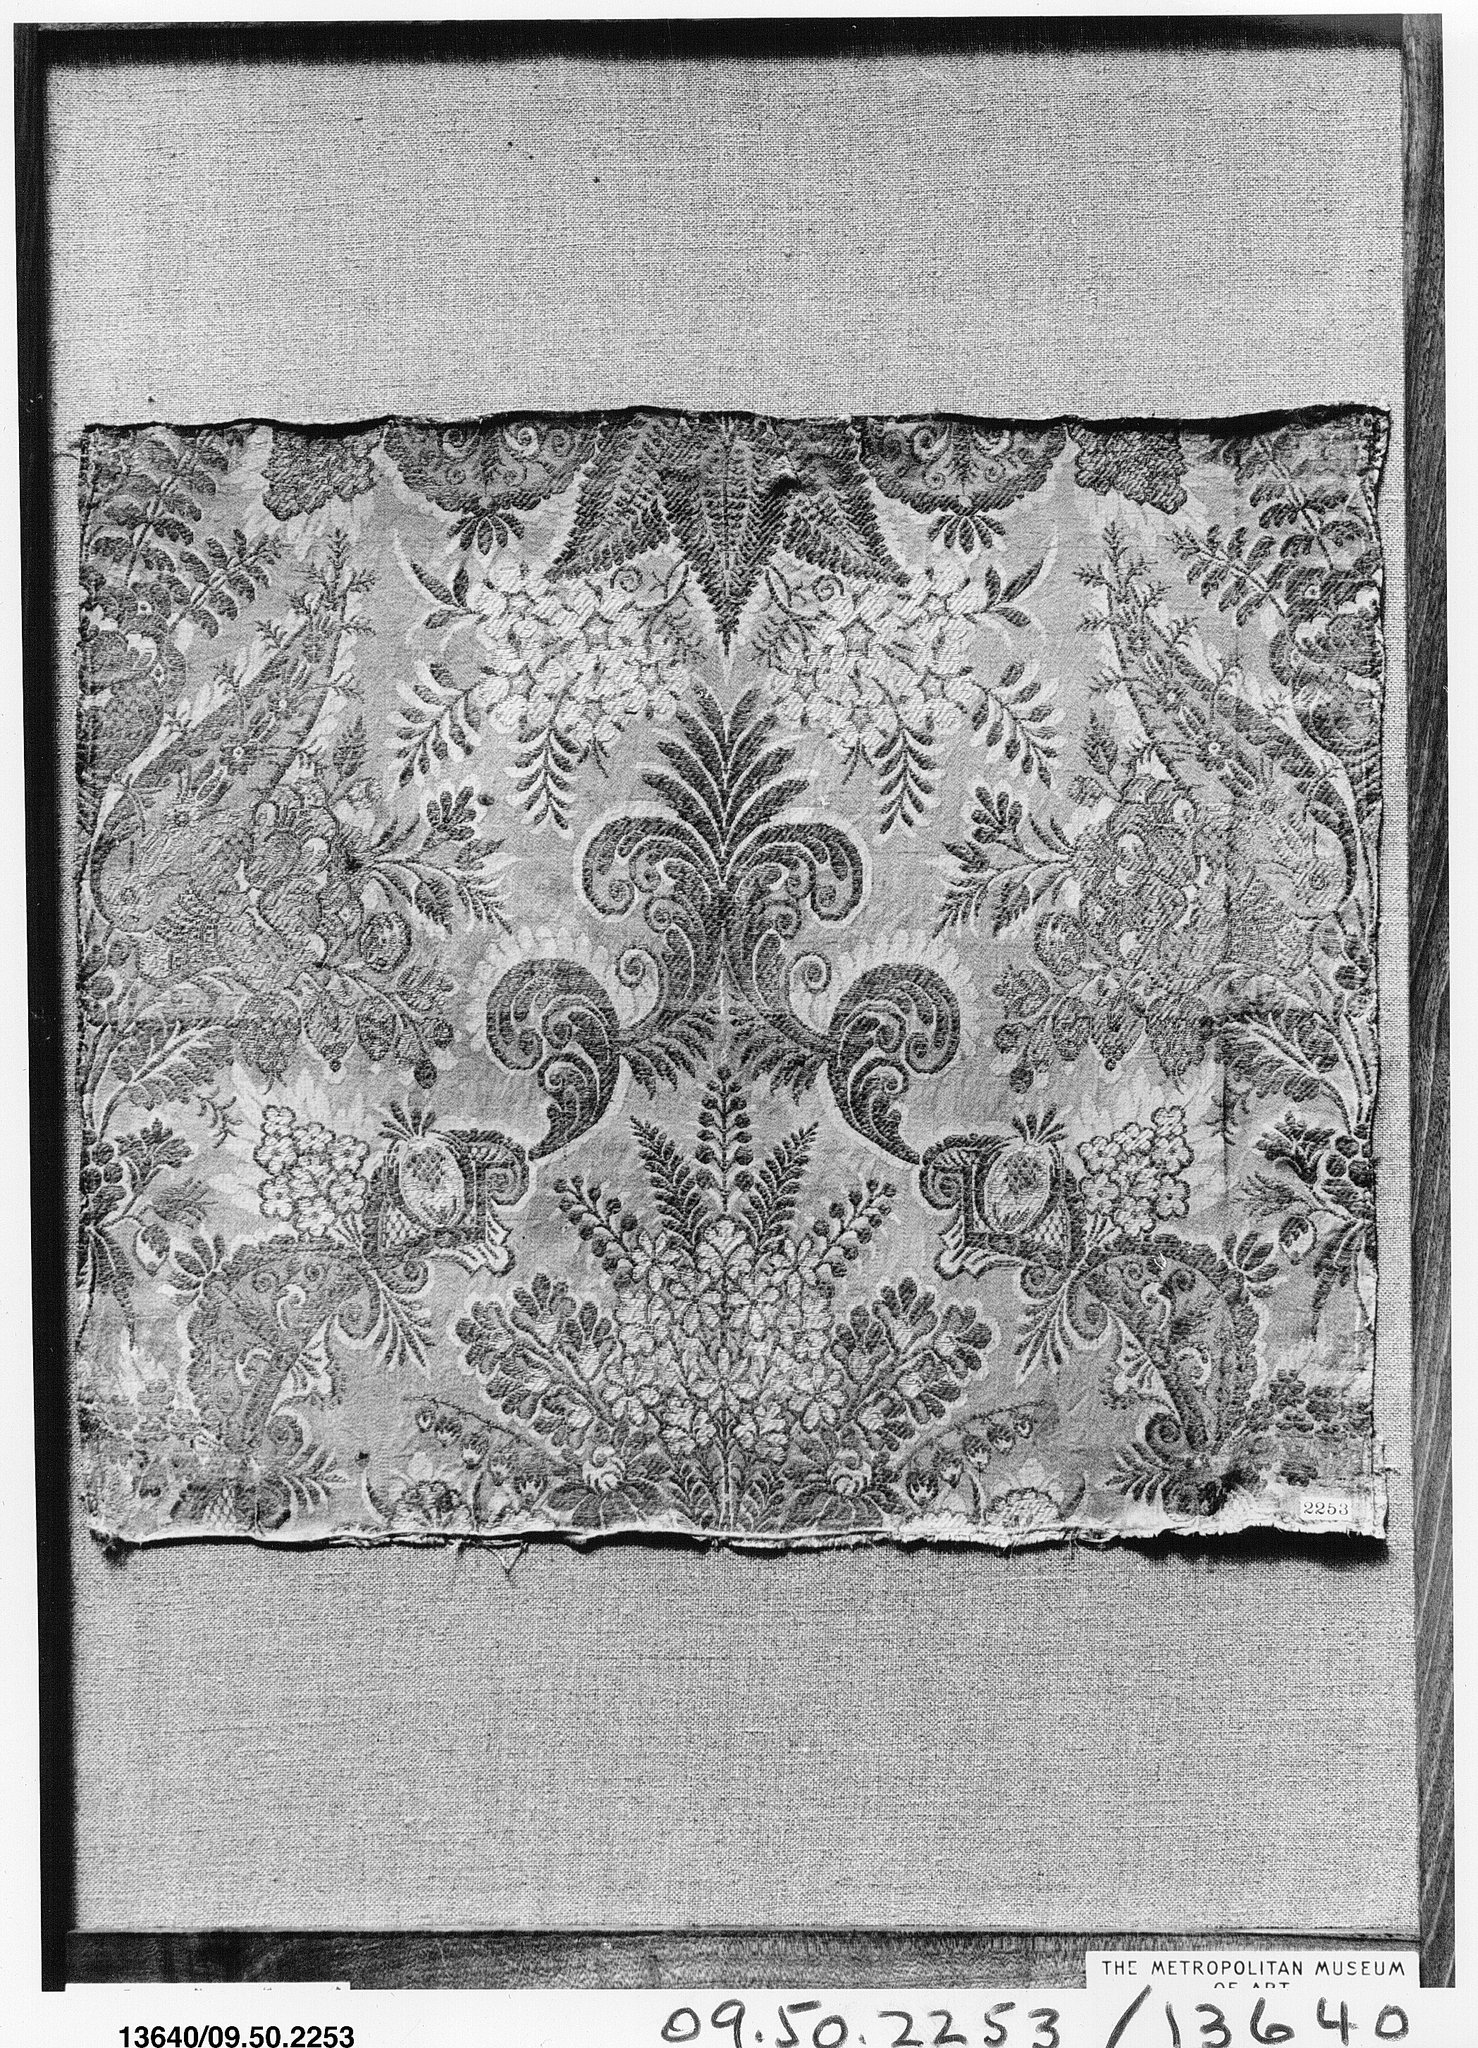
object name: piece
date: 1725-1730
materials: silk